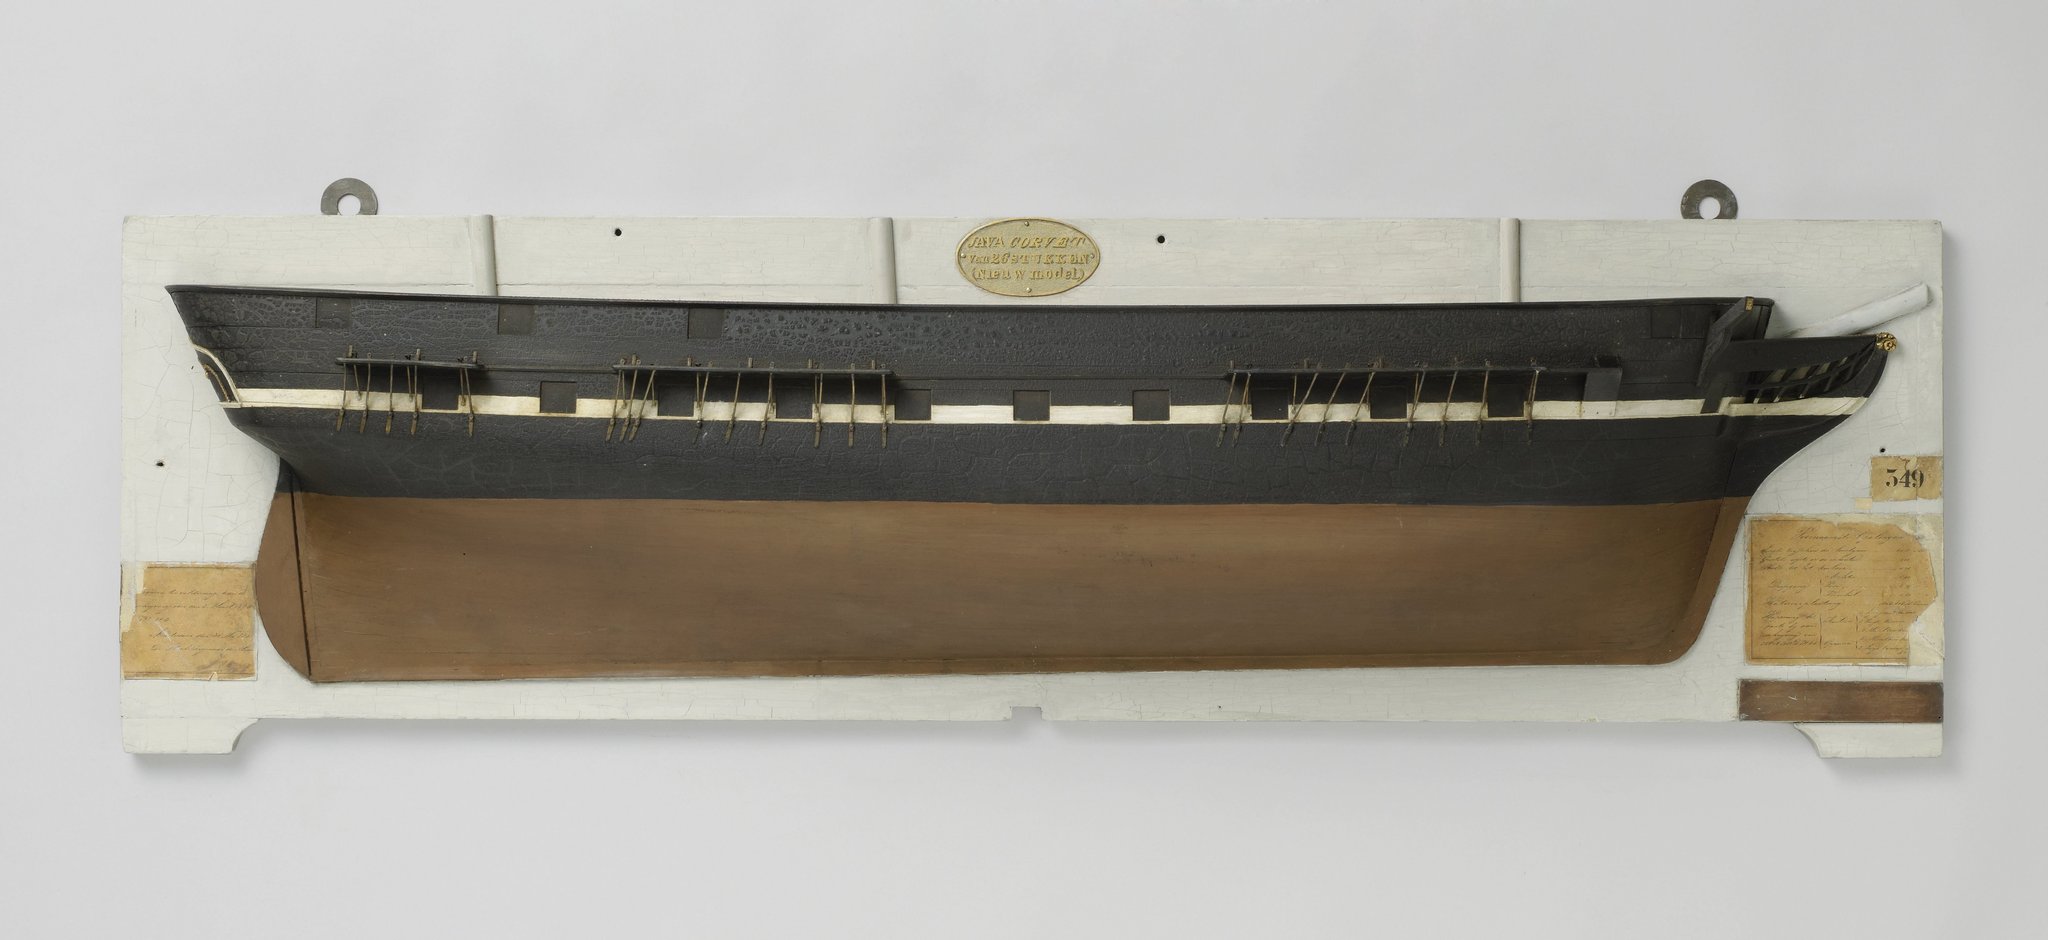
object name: builder's model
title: Half Model of a 26-Gun Sloop of War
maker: Anonymous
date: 1843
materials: brass, wood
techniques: polychromy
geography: amsterdam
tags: java (schip)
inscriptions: inscription, bottom right, on a piece of paper, in ink: ‘Voornaamste bepalingen / [followed by measurements and armament]’, scale, bottom right: brass scale, label, centre right: ‘349’ former inventory label, inscription, bottom left, on a piece of paper, in ink: ‘Verzonden ter voldoening aan de / aanschrijving van den 3 Maart 1846 / D Nr 103 / Amsterdam den 30 Mei 1851 / De Hoofdingenieur der Marine / Tromp’, inscription, top centre, on an oval label: ‘JAVA CORVET / Van 26 STUKKEN / (Nieuw Model)’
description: Gepolychromeerd beplankt mallenmodel (stuurboord) van een driemaster. Zestien geschutpoorten verdeeld over twee dekken. De scheg eindigt in een krul, die als schegbeeld dienst doet. Op de kraanbalk een rozet. Elliptisch hek van één verdieping, versierd met snijwerk, geen zijgalerij; roer met ronde roerkoning en afgerond roerblad. Het model is voorzien van alle rusten met jufferblokken. Zeeg naar voor en achter iets oplopend, één barkhout en één reehout. Gepiekt rondspant, scherp onderwaterschip. Schaal 1:40 (schaal op model).